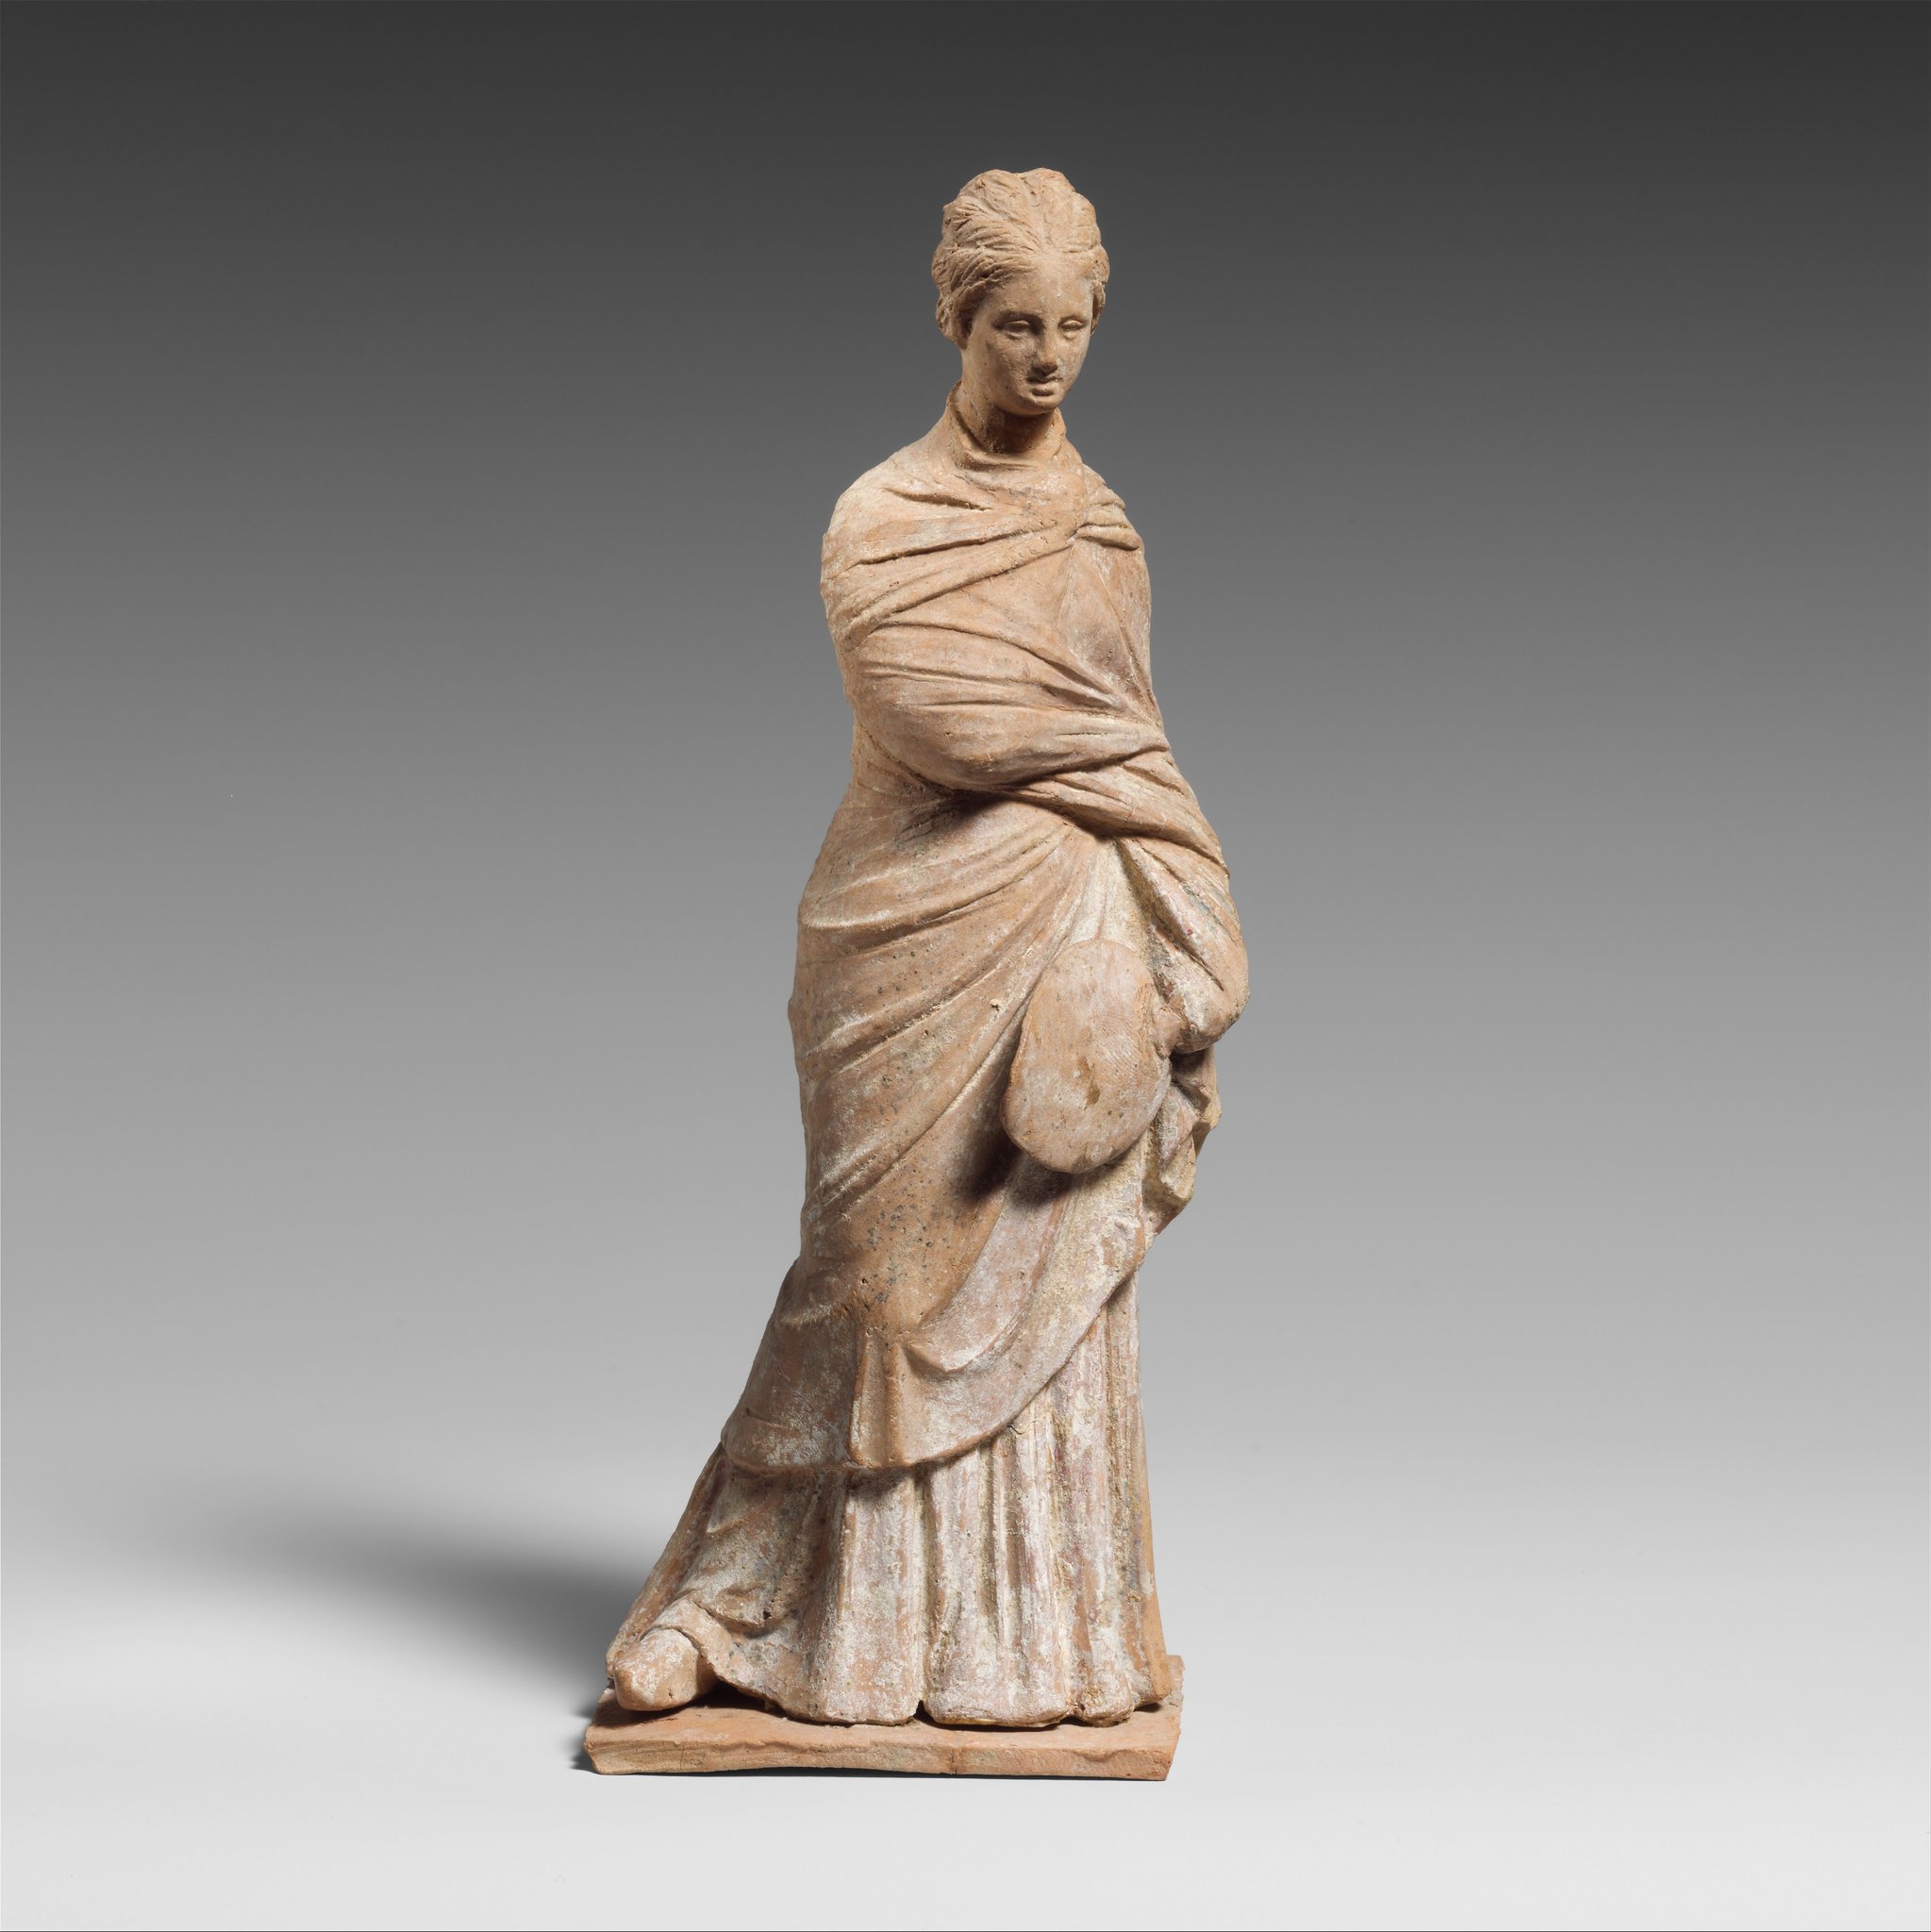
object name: statuette of a woman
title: Terracotta statuette of a draped woman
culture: greek, attic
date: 300-201 BCE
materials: terracotta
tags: fans,women